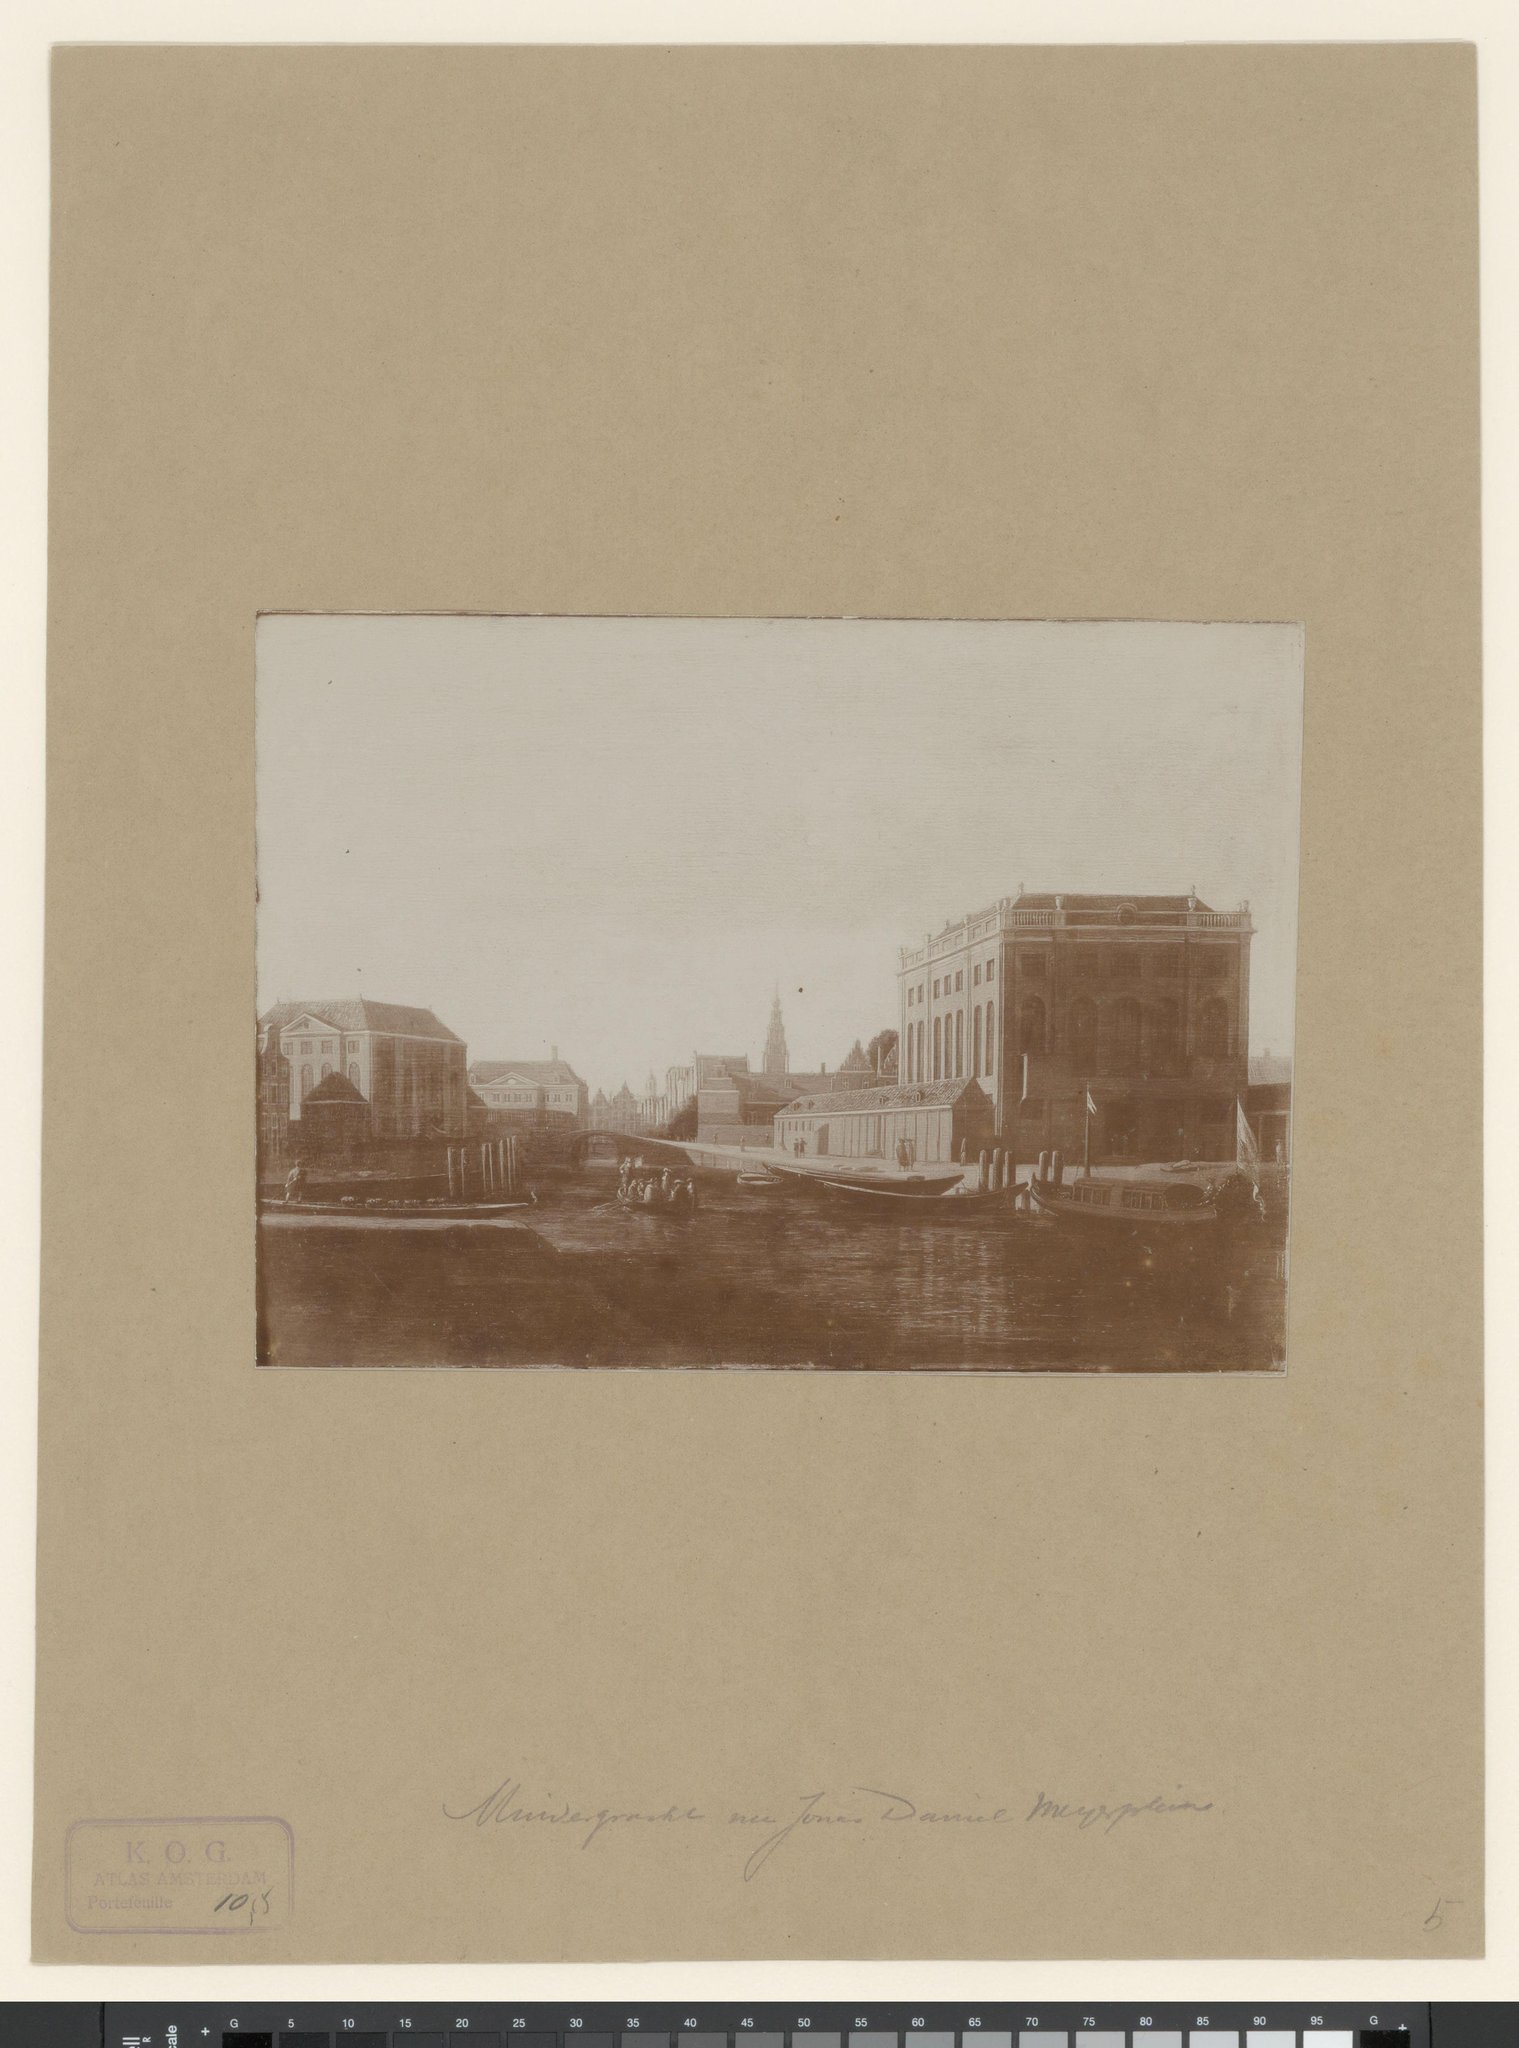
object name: photograph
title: Gezicht op de Muidergracht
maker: Anonymous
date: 1865-1940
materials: paper, cardboard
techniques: collodion silver print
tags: city-view in general; 'veduta', the synagogue (as building and place of worship ~ jewish religion), canal, boat propelled by man or animal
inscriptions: collector's mark: ‘10,15’ Lugt 1641b, collector's mark: Lugt 1641, inscription: ‘Muidergracht nu Jonas Daniel Meyerplein’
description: Onderwerpsrubriek binnen de Atlas Amsterdam: Maagdelievenstraat, Markenplein, Marnixstraat, Martelaarsgracht, Meeuwenlaan, Mennonietenpad, Meijerplein (Jonas Daniël), Mozes en Aäronstraat, Muidergracht, Muntplein.